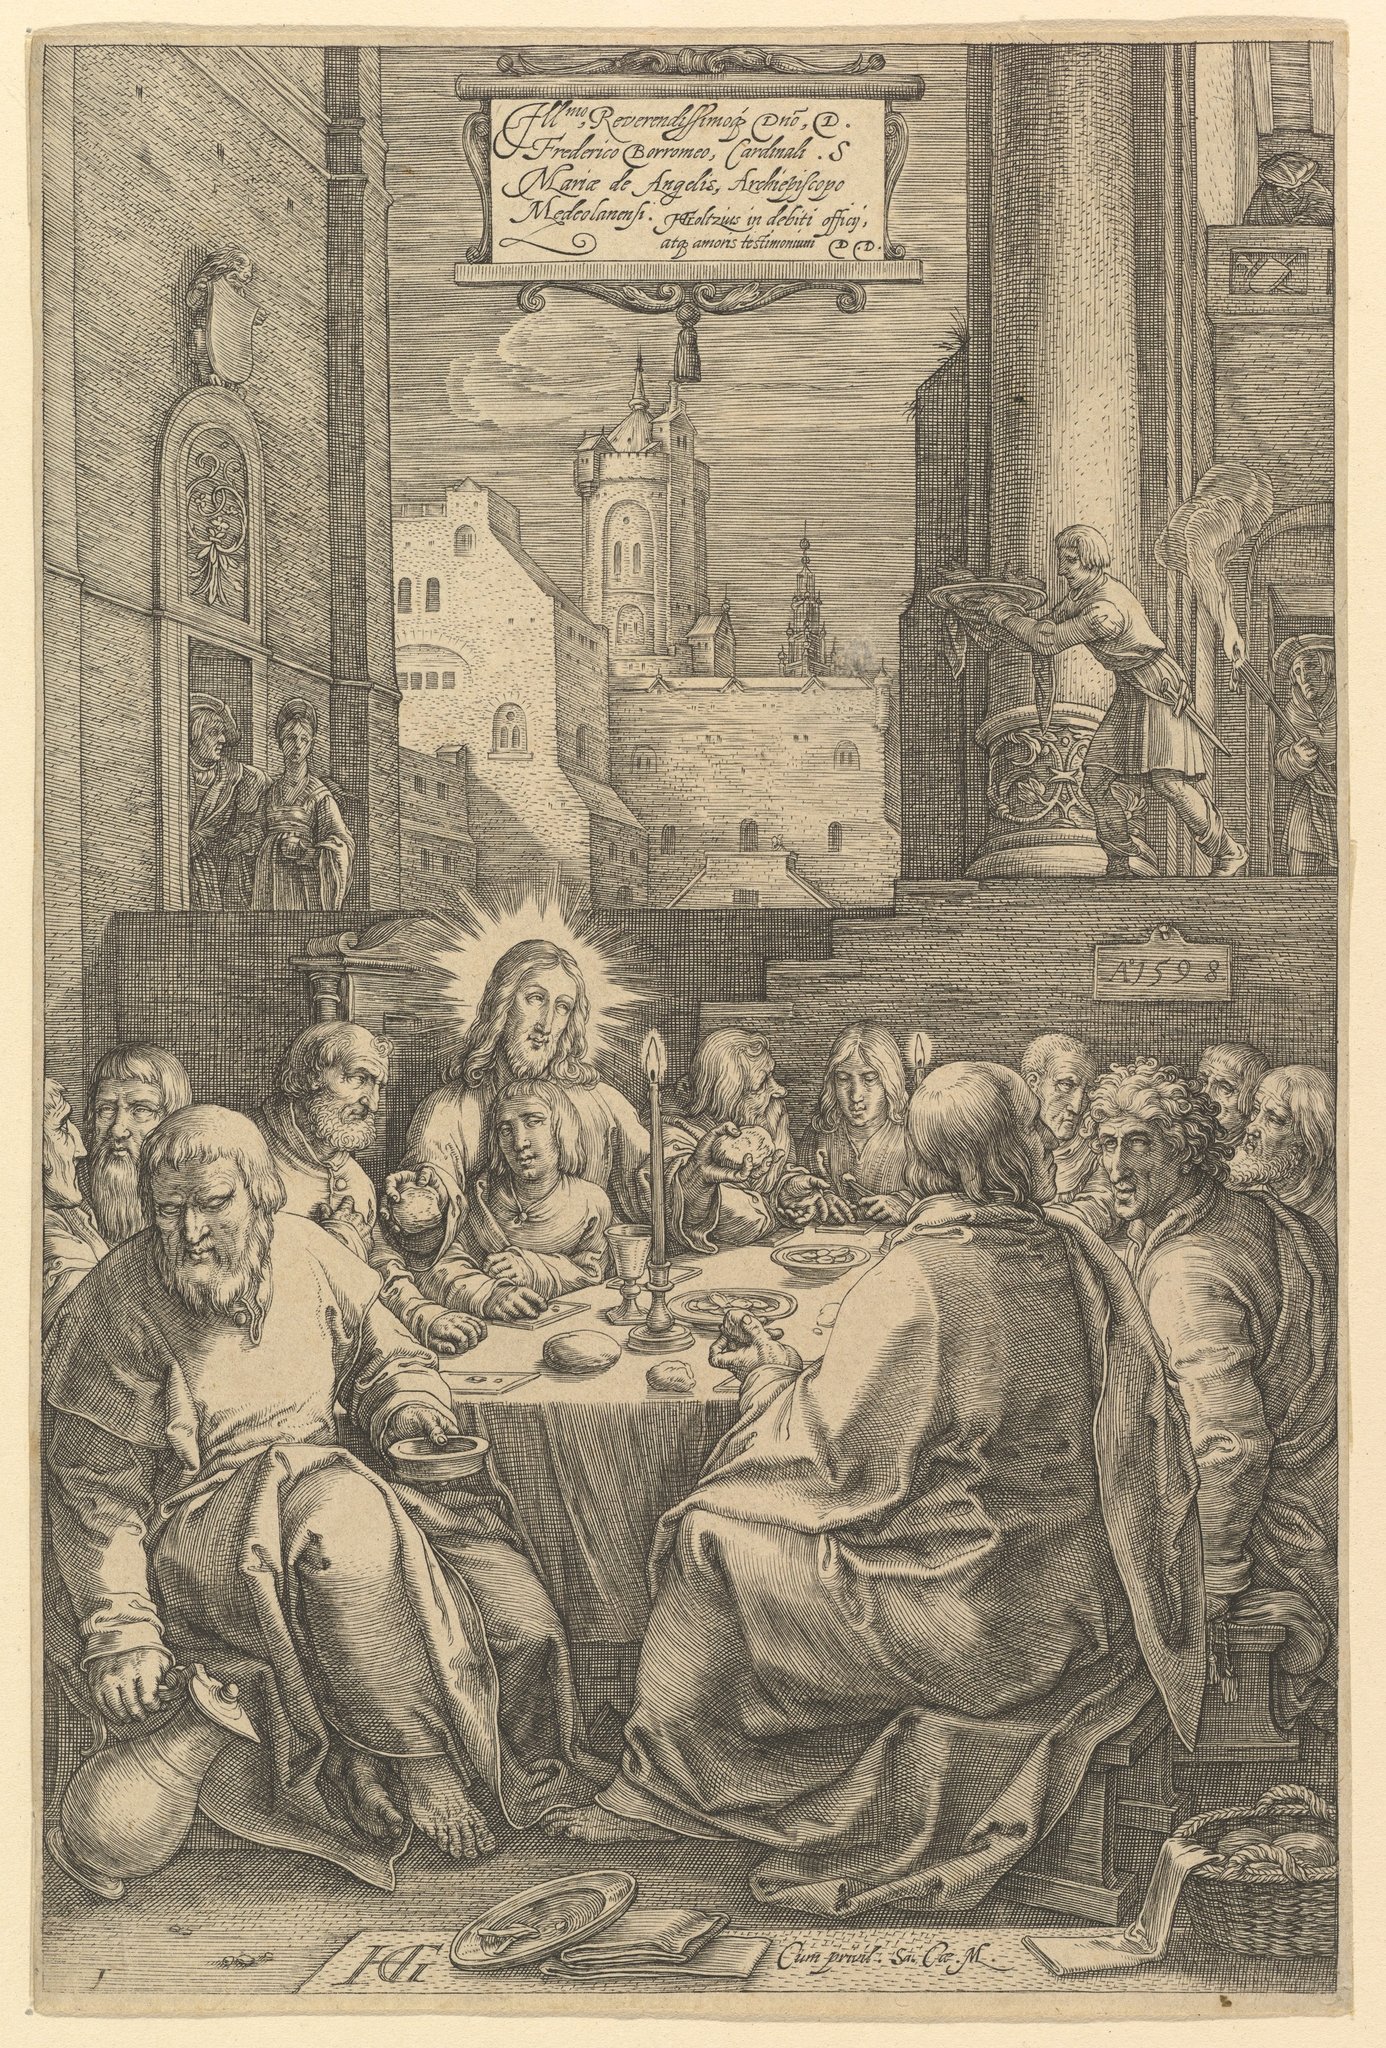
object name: print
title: The Last Supper, from "The Passion of Christ"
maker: hendrick goltzius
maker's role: artist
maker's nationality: netherlandish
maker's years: 1558-1617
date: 1598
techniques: engraving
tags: food,men,women,christ,last supper,dining